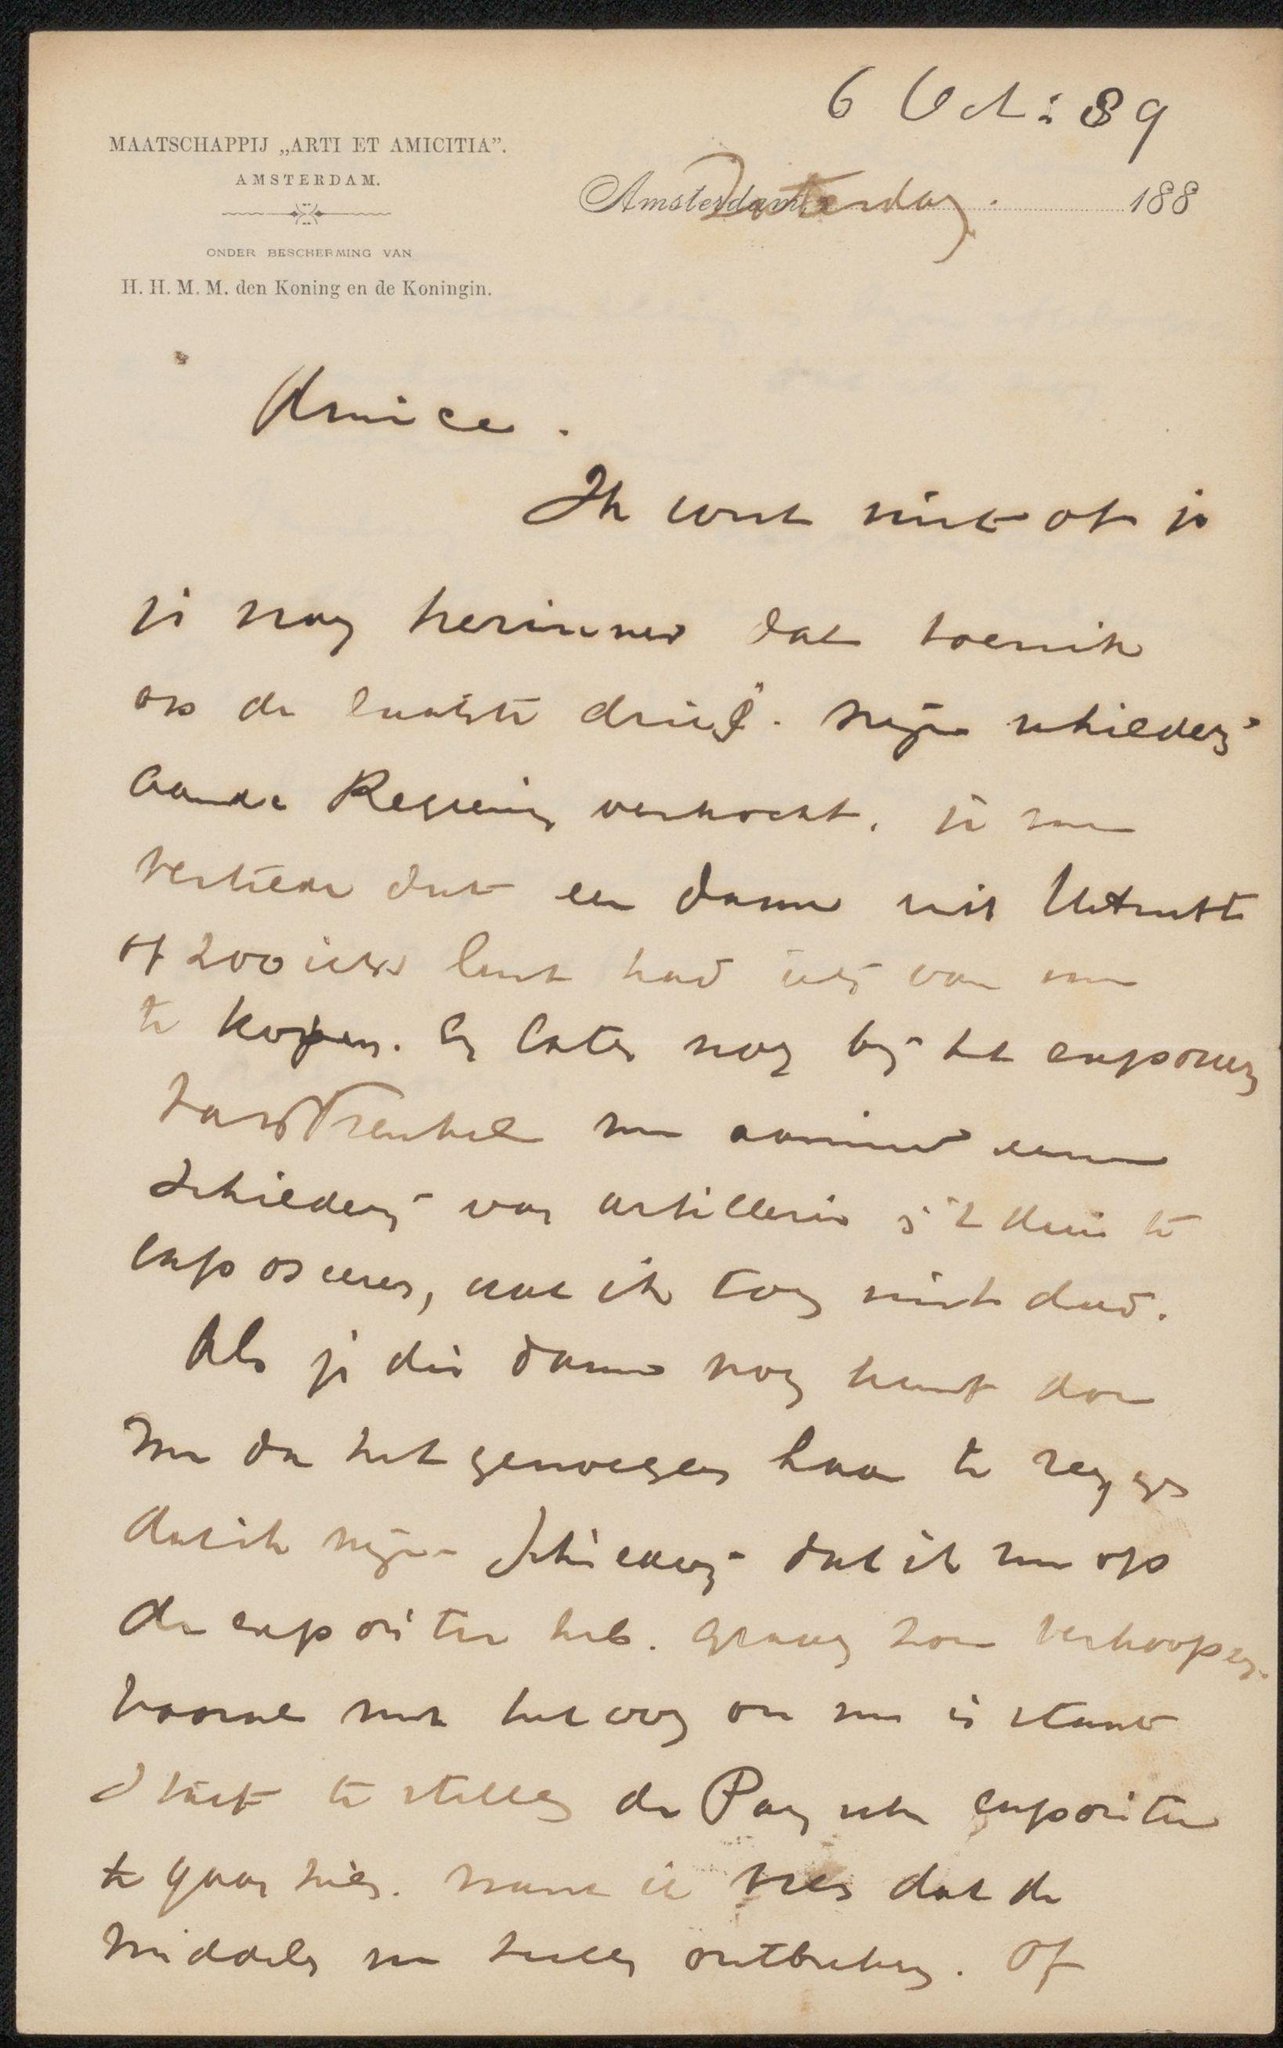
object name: letter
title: Brief aan Jan Veth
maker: george hendrik breitner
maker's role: draughtsman, painter, print maker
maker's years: 1857-1923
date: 1889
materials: ink, paper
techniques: pen, printing, writing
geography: amsterdam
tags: dordrecht, designer, jan veth, art trade, art shop, painting (including book-illumination, miniature-painting), exhibition ~ art, art collecting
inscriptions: collector's mark: ‘RPK’